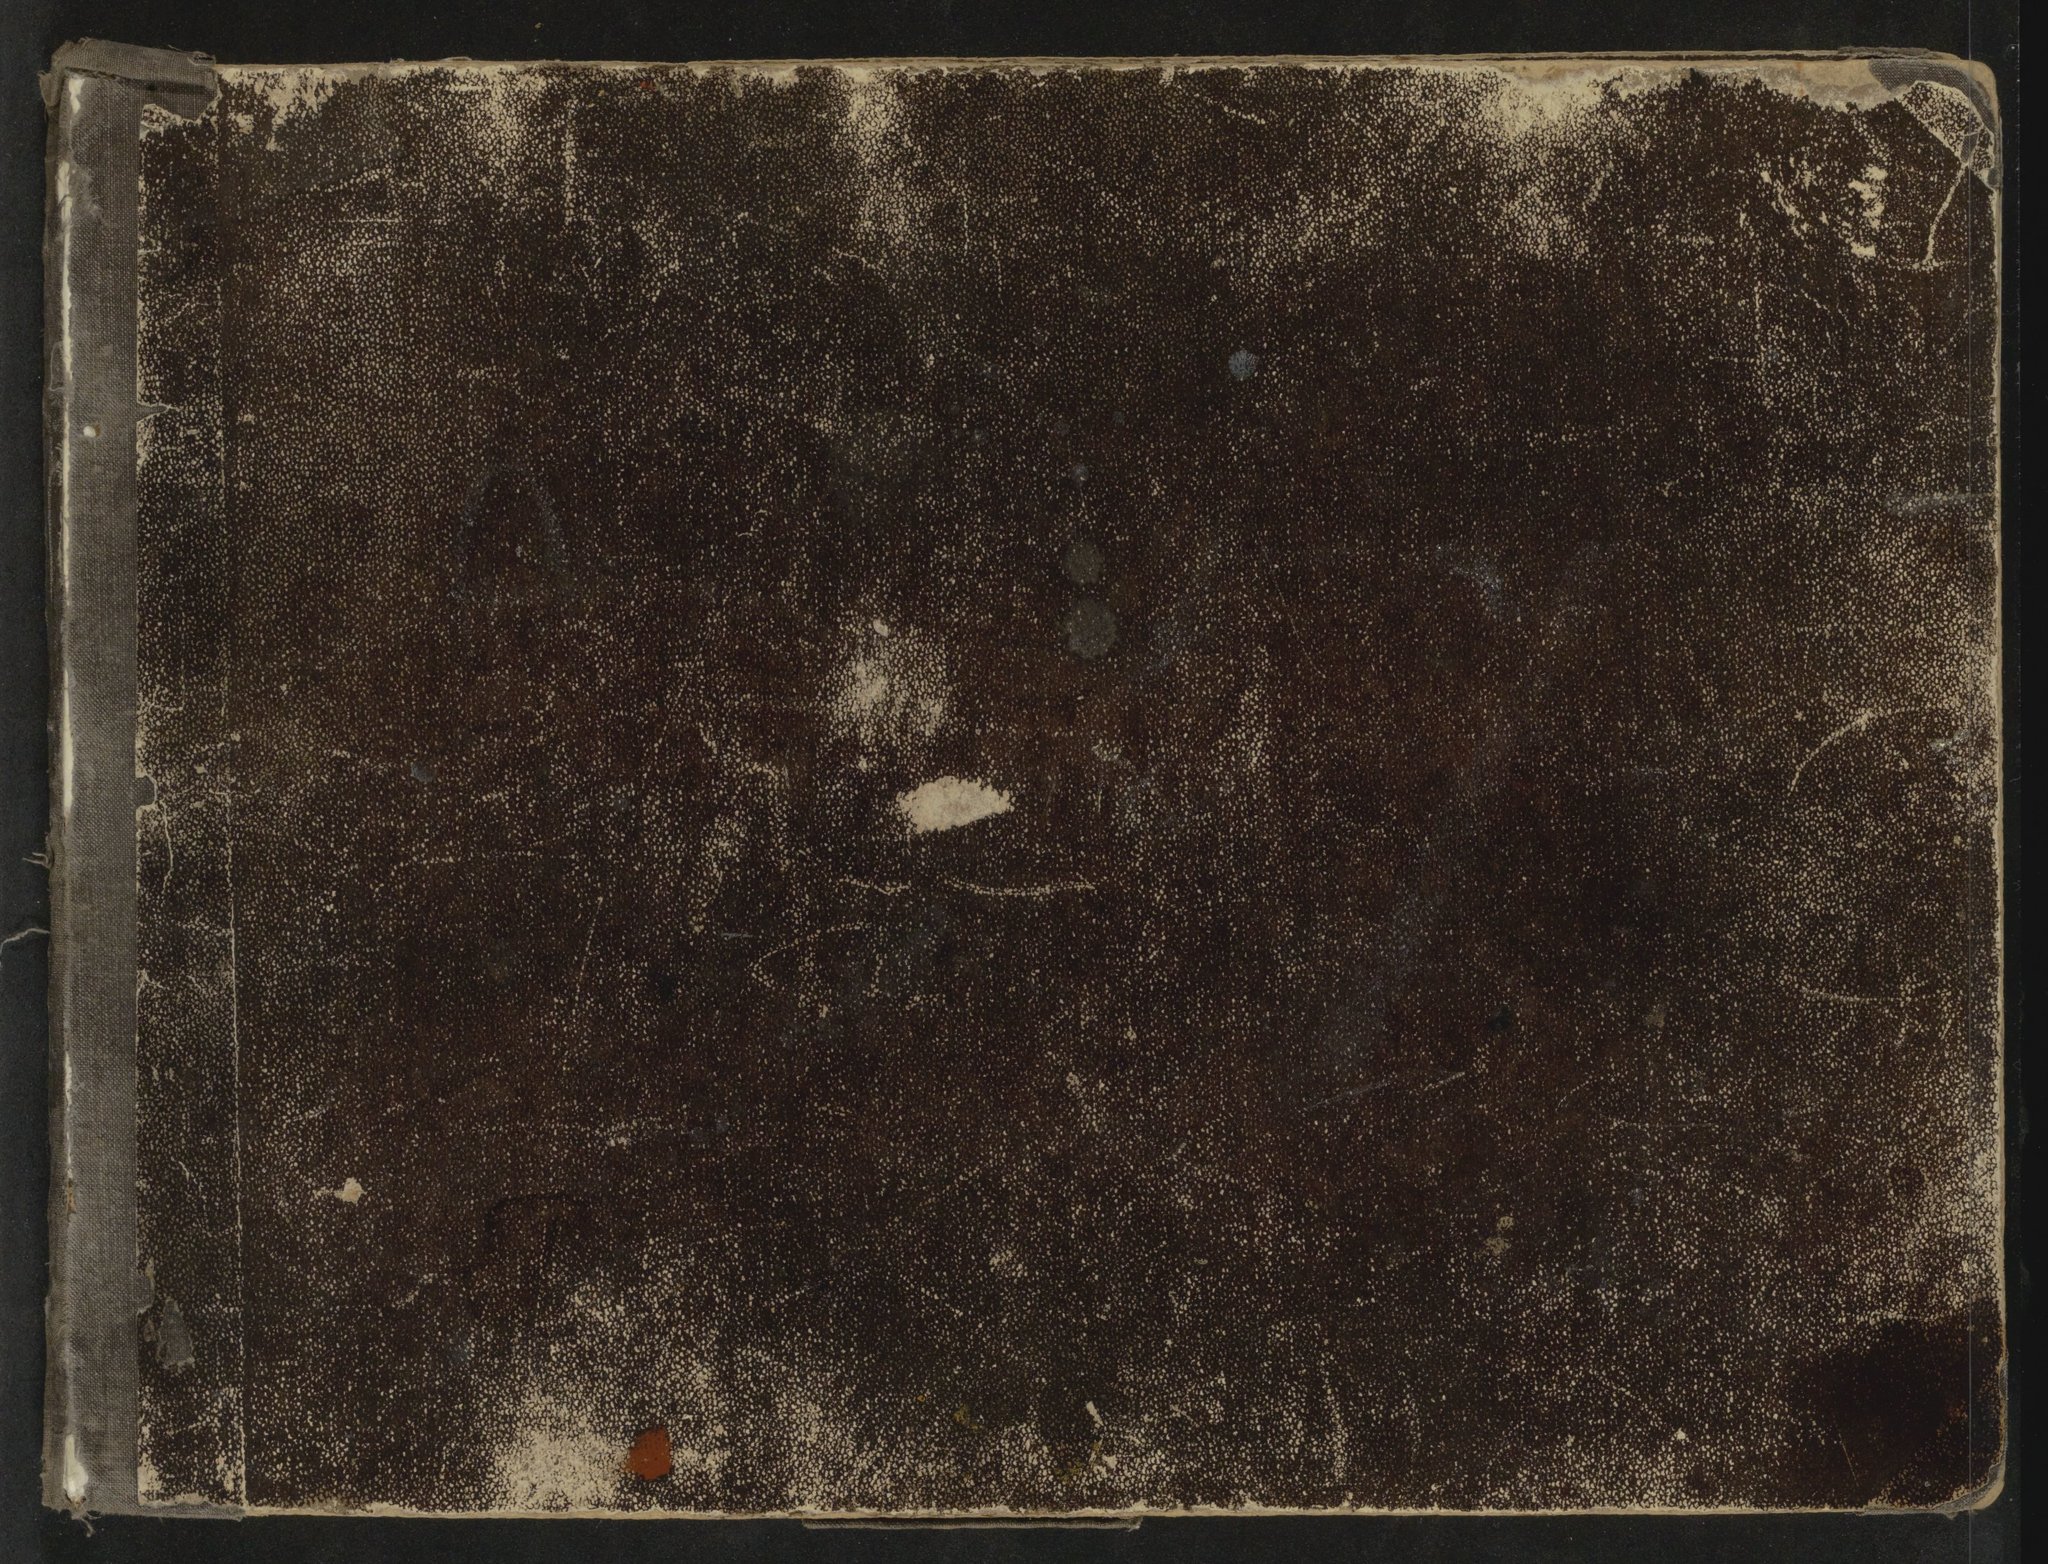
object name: sketchbook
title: Schetsboek met 43 bladen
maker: albert neuhuys (1844-1914)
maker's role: draughtsman, painter, print maker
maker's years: 1844-1914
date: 1854-1914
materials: cardboard, chalk, charcoal, leather, linen, paper, pencil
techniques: brush, stumping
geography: laren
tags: landscapes, anatomy (non-medical), farmers, interior of the house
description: Tussen blad 20 en 21 is één blad ongenummerd gebleven. Dit blad heeft een subnummer gekregen om de volgorde van de genummerde bladen te behouden. De volgende bladen uit het schetsboek zijn blanco: 1(V), 5(R), 5(V), 6(V), 9(V), 13(V), 14(V), 16(R), 23(V), 25(R), 27(R), 29(R), 31(R), 36(R), 37(V), 38(R).